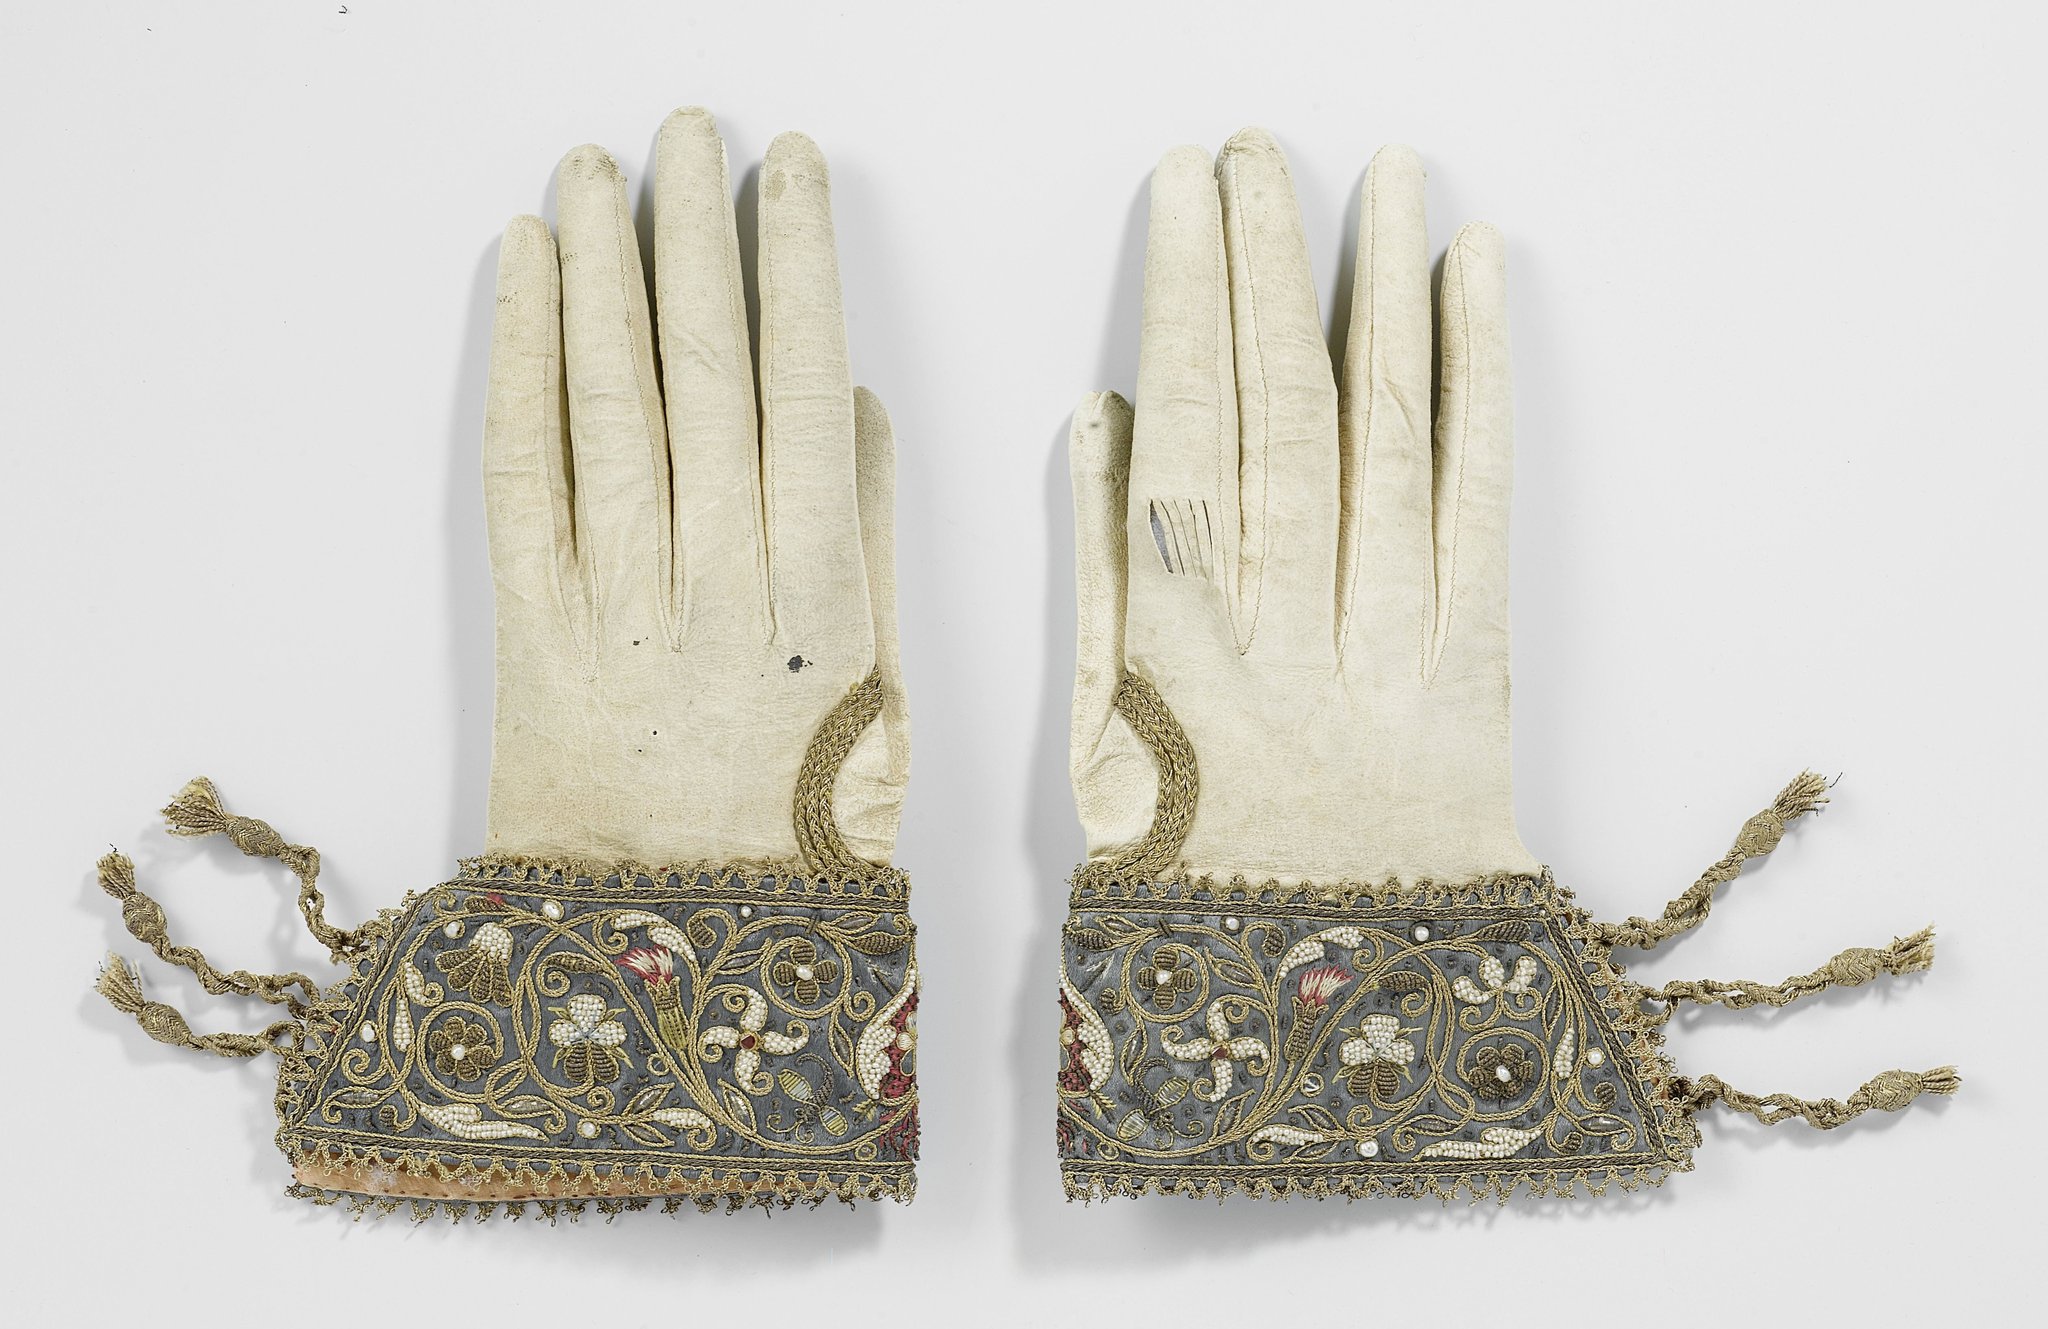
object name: bruidshandschoen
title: Bruidshandschoen van wasleer met losse kappen van blauw/grijs satijn versierd met borduurwerk in veelkleurige zijde, zilverdraad, zoetwaterparels, robijntjes(?) en zilveren lovertjes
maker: Anonymous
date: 1600-1625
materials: gold thread, linen, pearl, gemstone, silk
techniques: lace, braiding, embroidered, tanning, weave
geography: northern netherlands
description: Paar handschoenen, kalfsleer, satijn, zoetwater parels, robijnen, floszijde, metalen strookjes, zilver cantille, zilveren lovers, goud- en zilverdraad, goudkant, zijde Nederland, ca. 1625 Inv. BK-KOG-20 In de rechter wijsvinger verticale insnijdingen om (trouw)ring zichtbaar te maken. Pair of gloves, kid, satin, seed pearls, rubies, floss silk, metal bands, silver cannetille, silver sequins, gold- and silverthread, gold lace, silk Netherlands, ca. 1625 Inv. BK-KOG-20 Vertical cuts in the righthand index-finger to expose the (wedding)ring